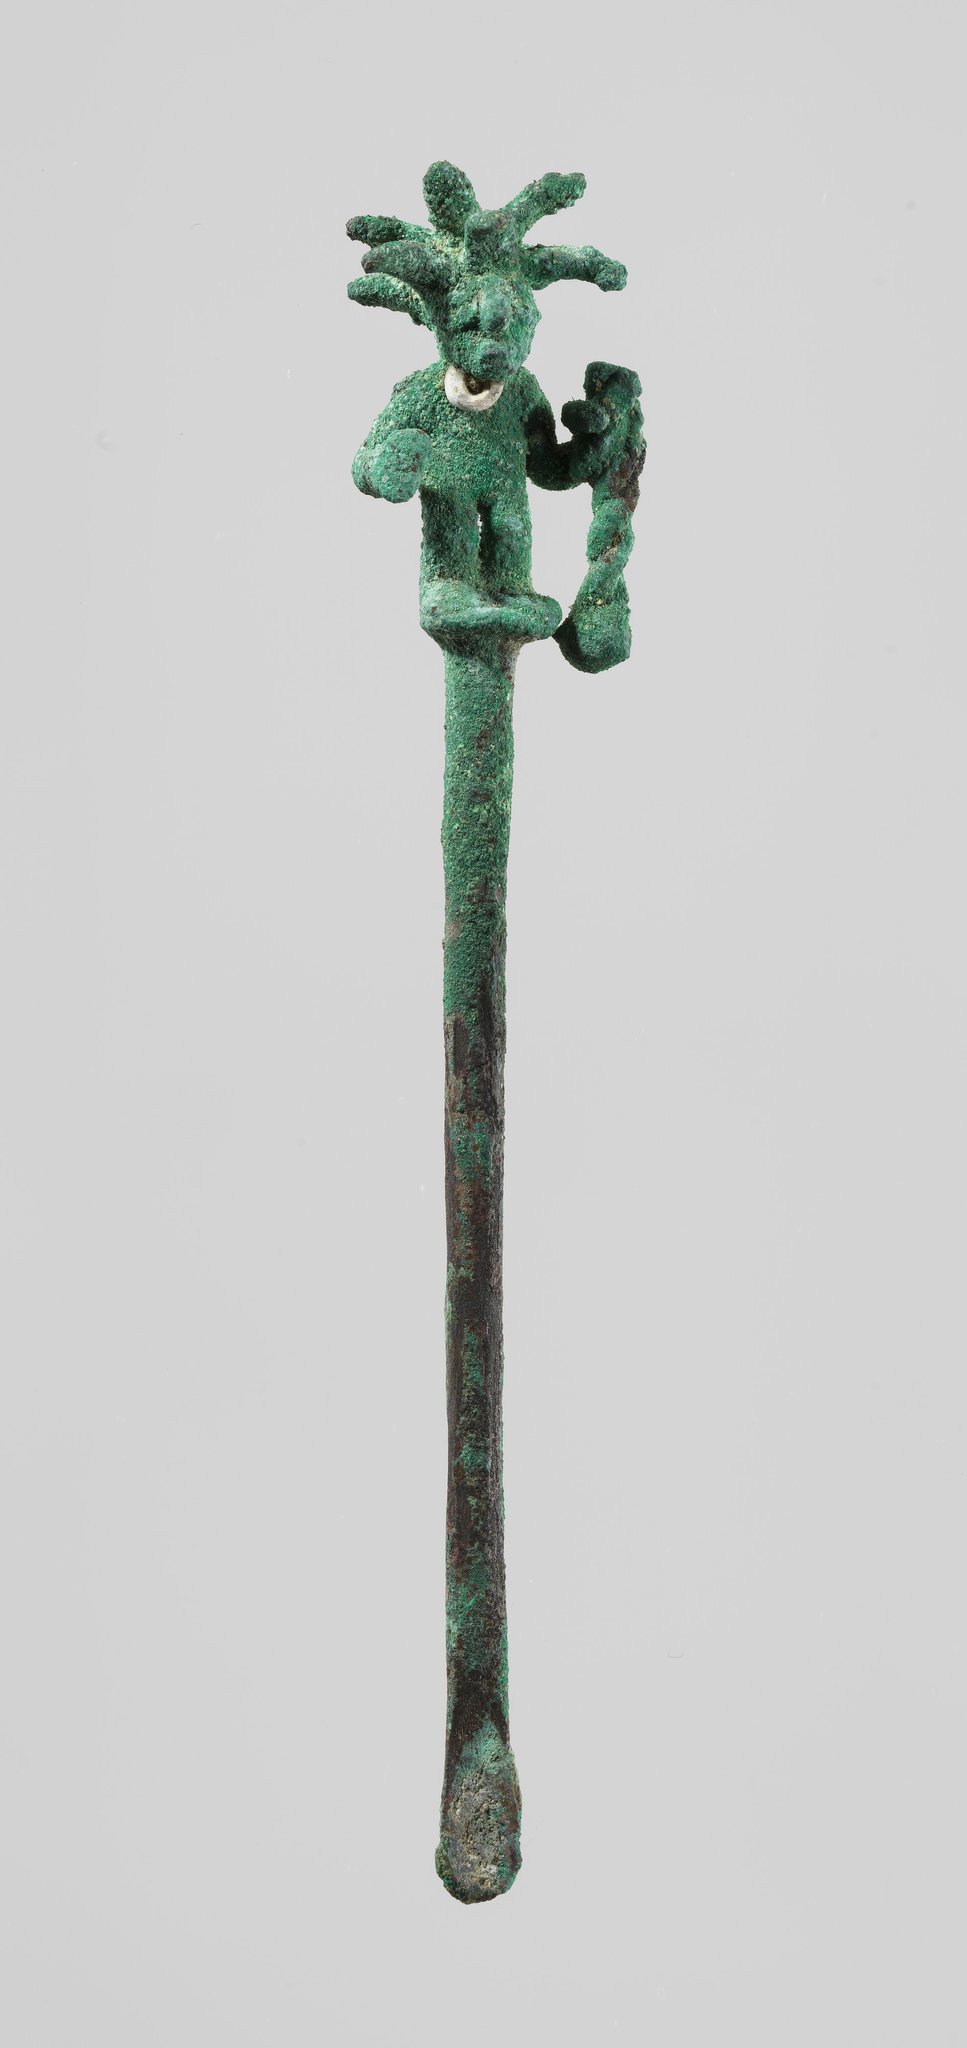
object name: lime spoon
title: Figure Lime Spoon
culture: inca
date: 1401-1600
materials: copper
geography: peru